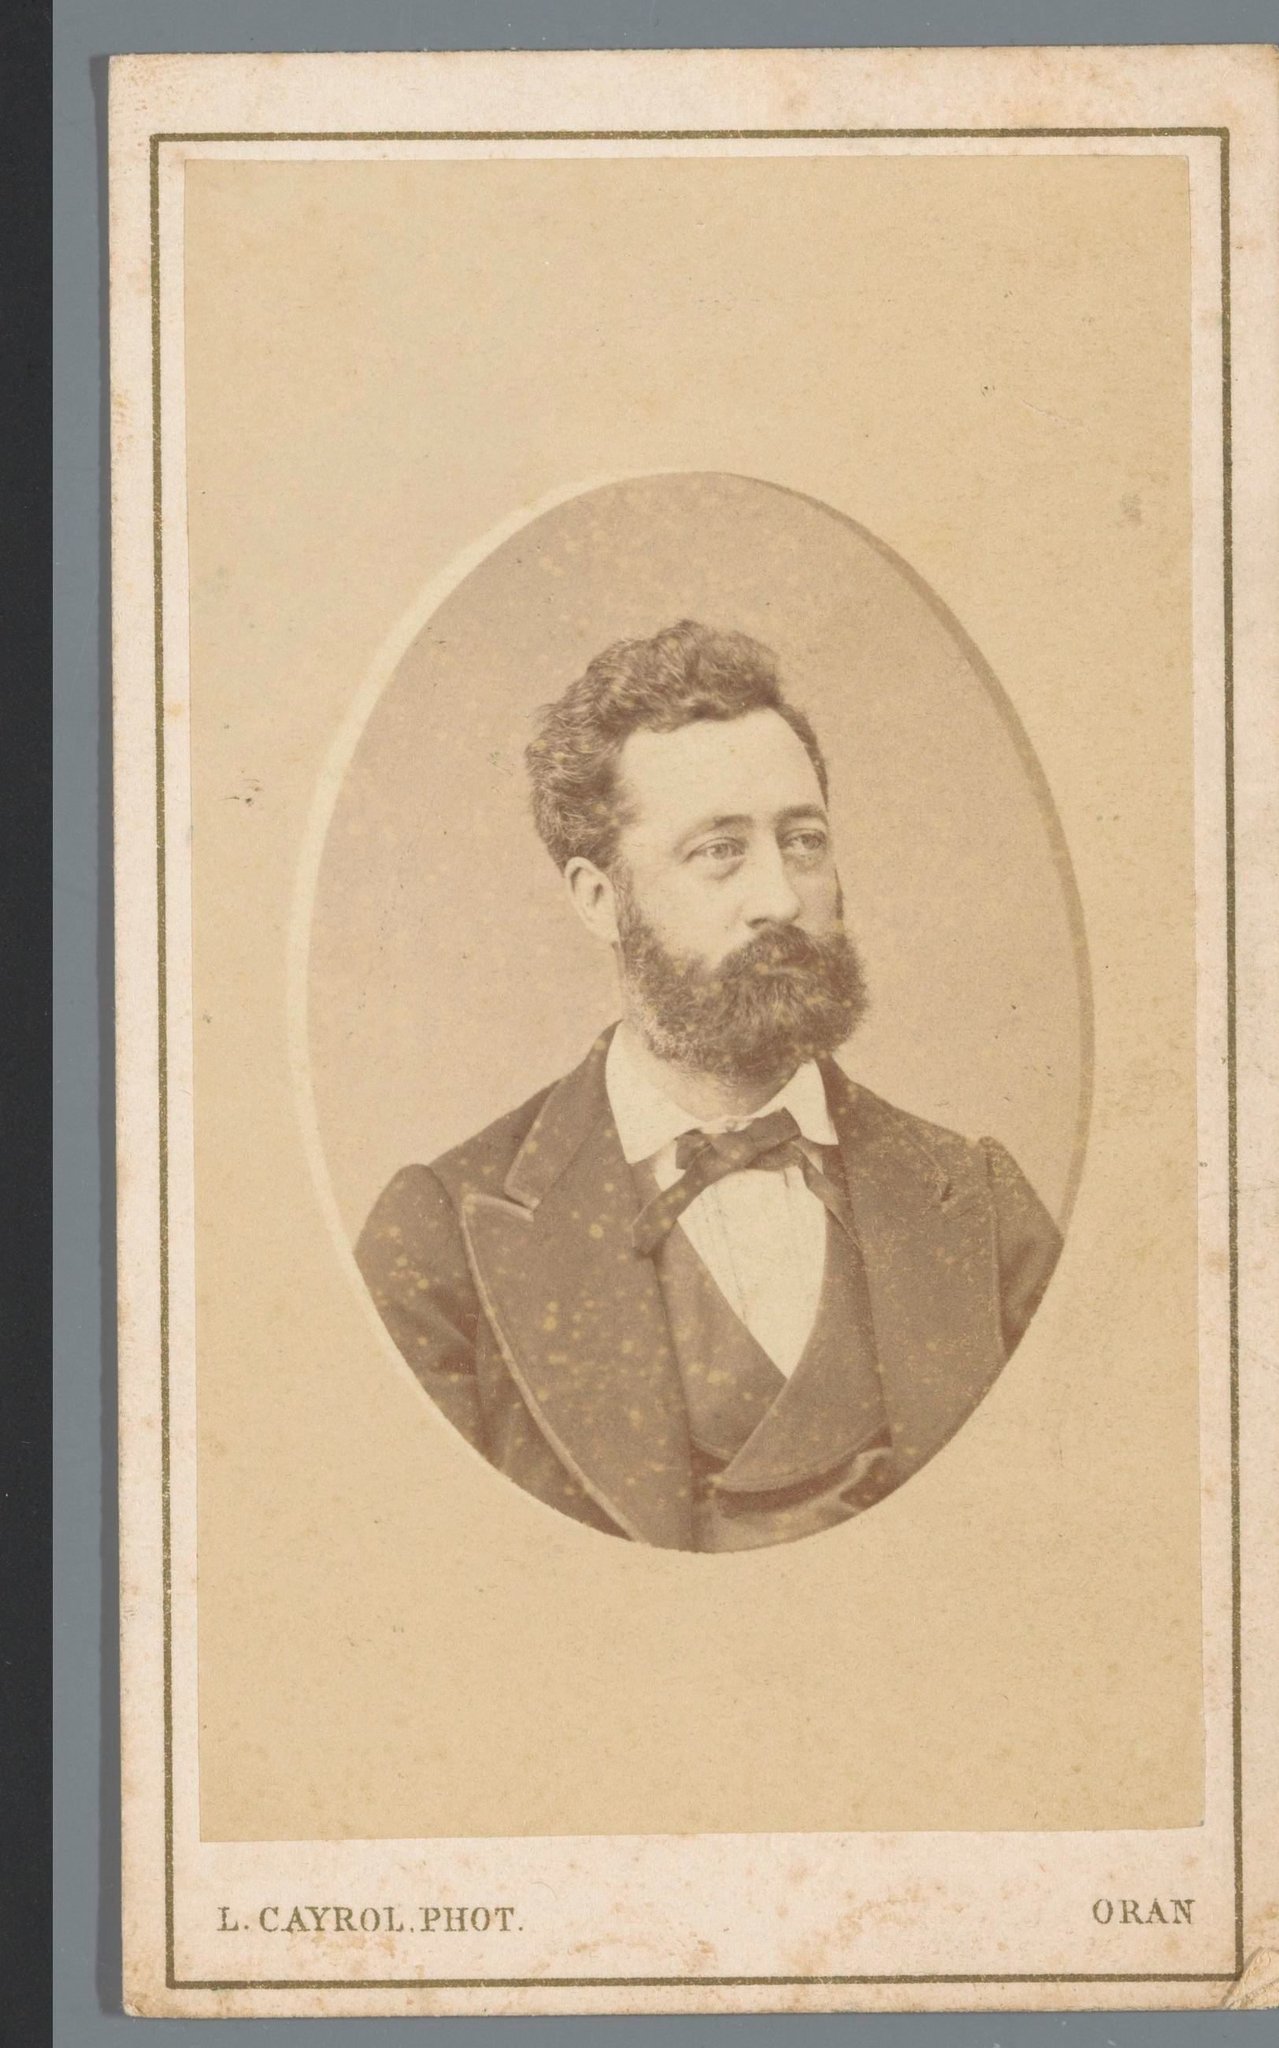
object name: photograph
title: Portret van Henri Voisard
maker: léon cairol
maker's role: painter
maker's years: 1843-1895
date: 1871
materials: cardboard, paper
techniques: albumen print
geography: oran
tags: adult man, historical persons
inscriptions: inscription: ‘L. Cayrol, phot. Oran’, inscription: ‘Souvenir d'amitié/ à mon frère Geo. Albert/ Oran, 26 Avril 71/ H.ri Voisard’, inscription: ‘L. Cayrol/ Peintre & Photographe/ Boulevard Malakoff/ Oran/ Les Clichés sont conservés/ No...’